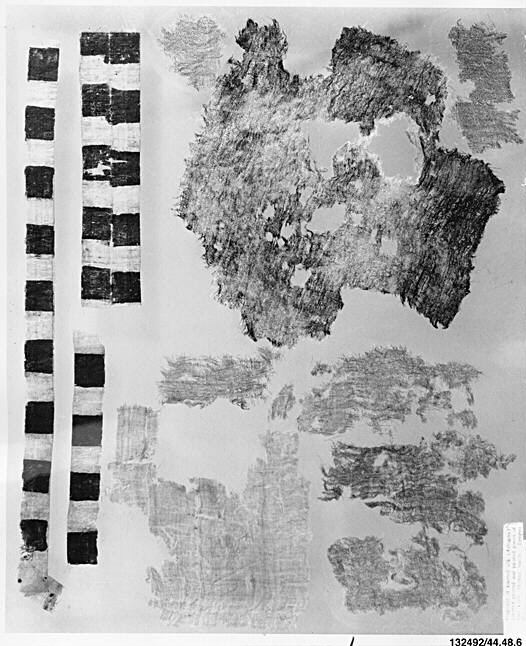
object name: fragment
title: Fragments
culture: japanese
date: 701-800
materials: textile